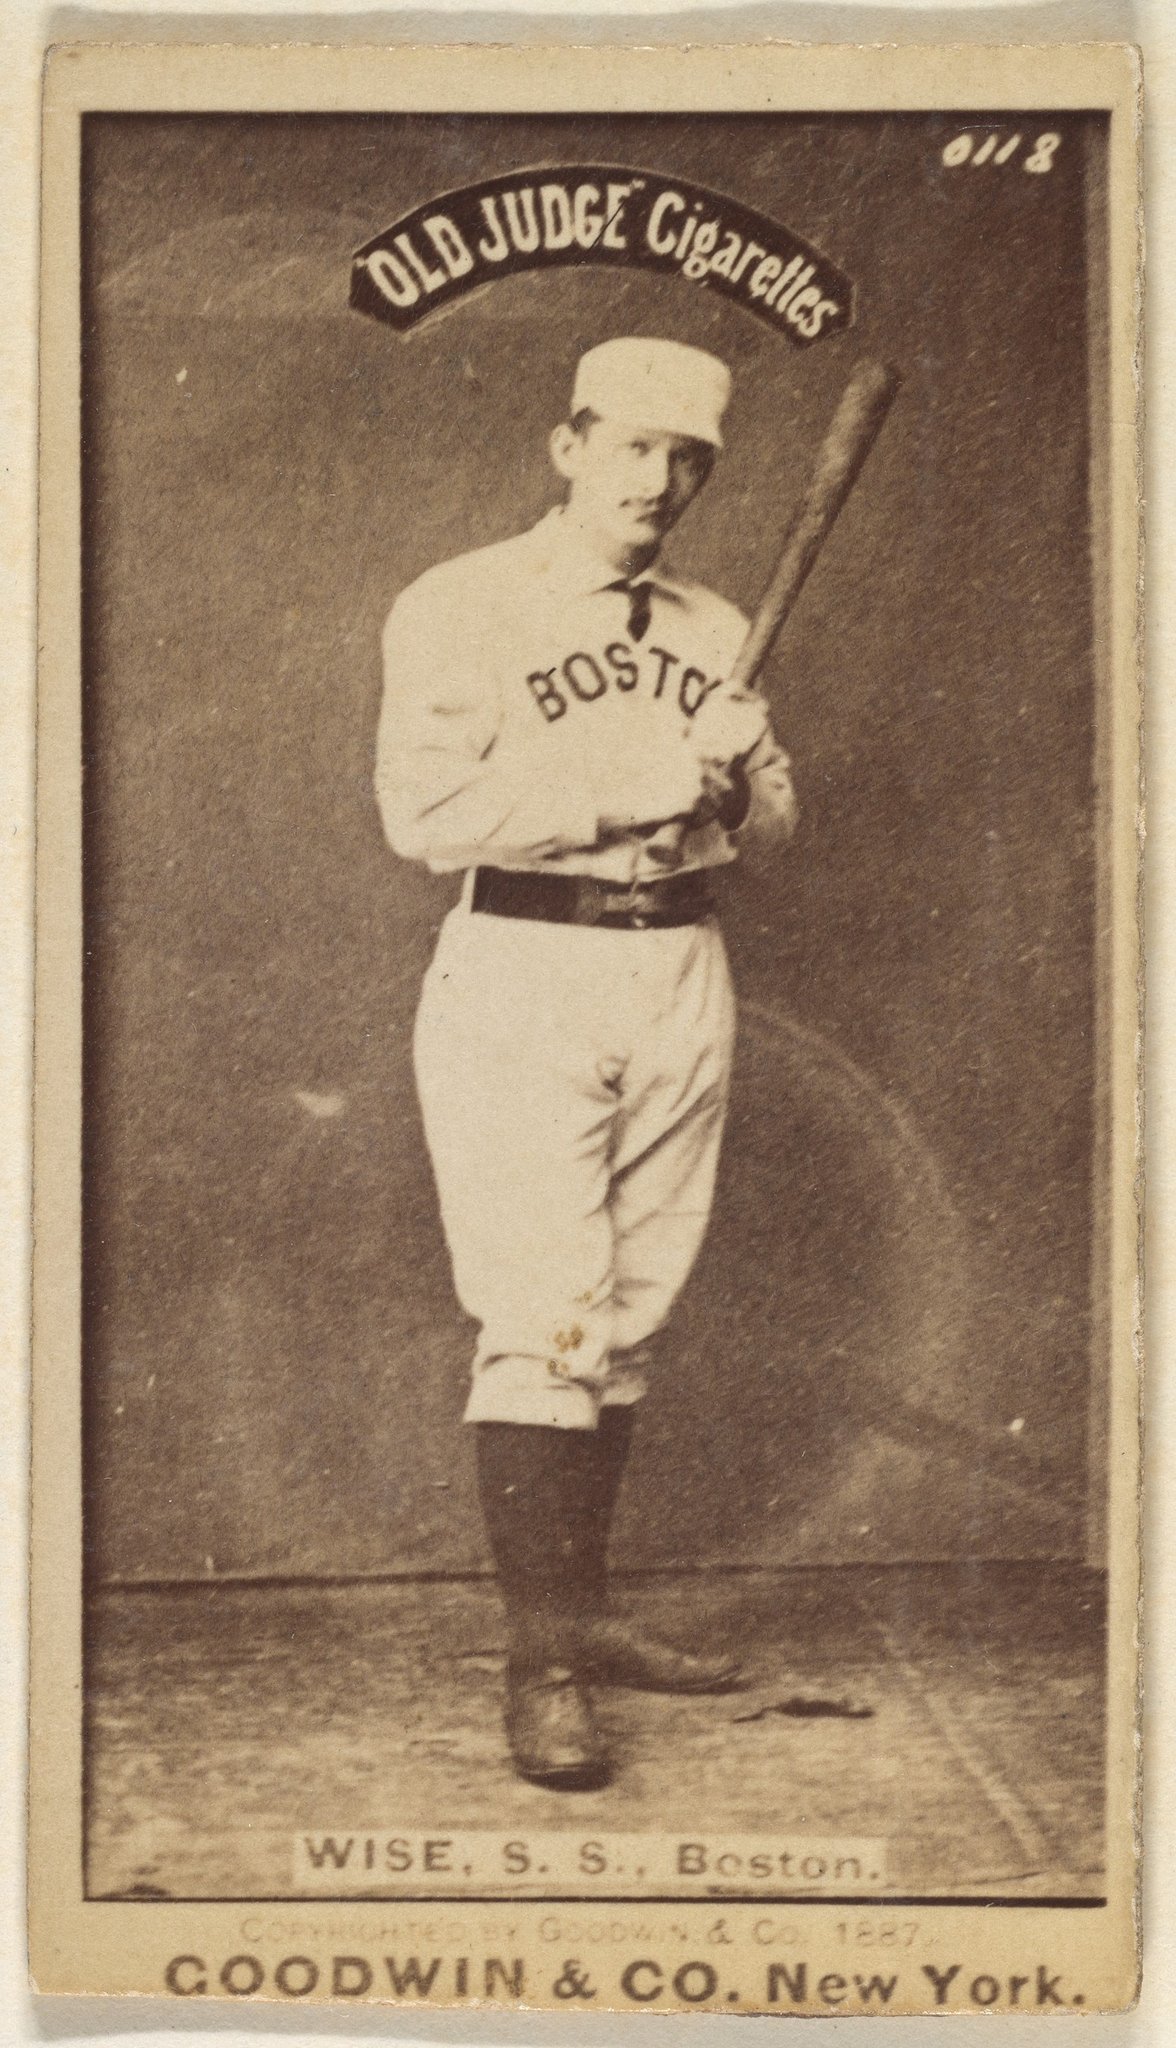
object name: baseball card, photograph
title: Wise, Shortstop, Boston, from the Old Judge series (N172) for Old Judge Cigarettes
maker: goodwin & company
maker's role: publisher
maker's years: 1850-1950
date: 1887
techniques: albumen silver print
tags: men,portraits,baseball,athletes